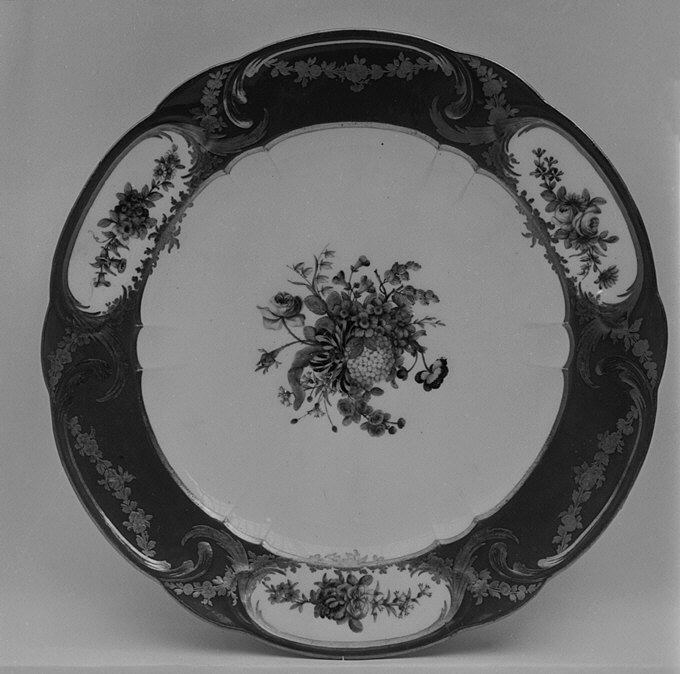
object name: plate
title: Plate (Assiette à palmes) (1 of 102) (part of a service)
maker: sèvres manufactory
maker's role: manufactory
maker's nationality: french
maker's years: 1740-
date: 1775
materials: soft paste porcelain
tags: flowers